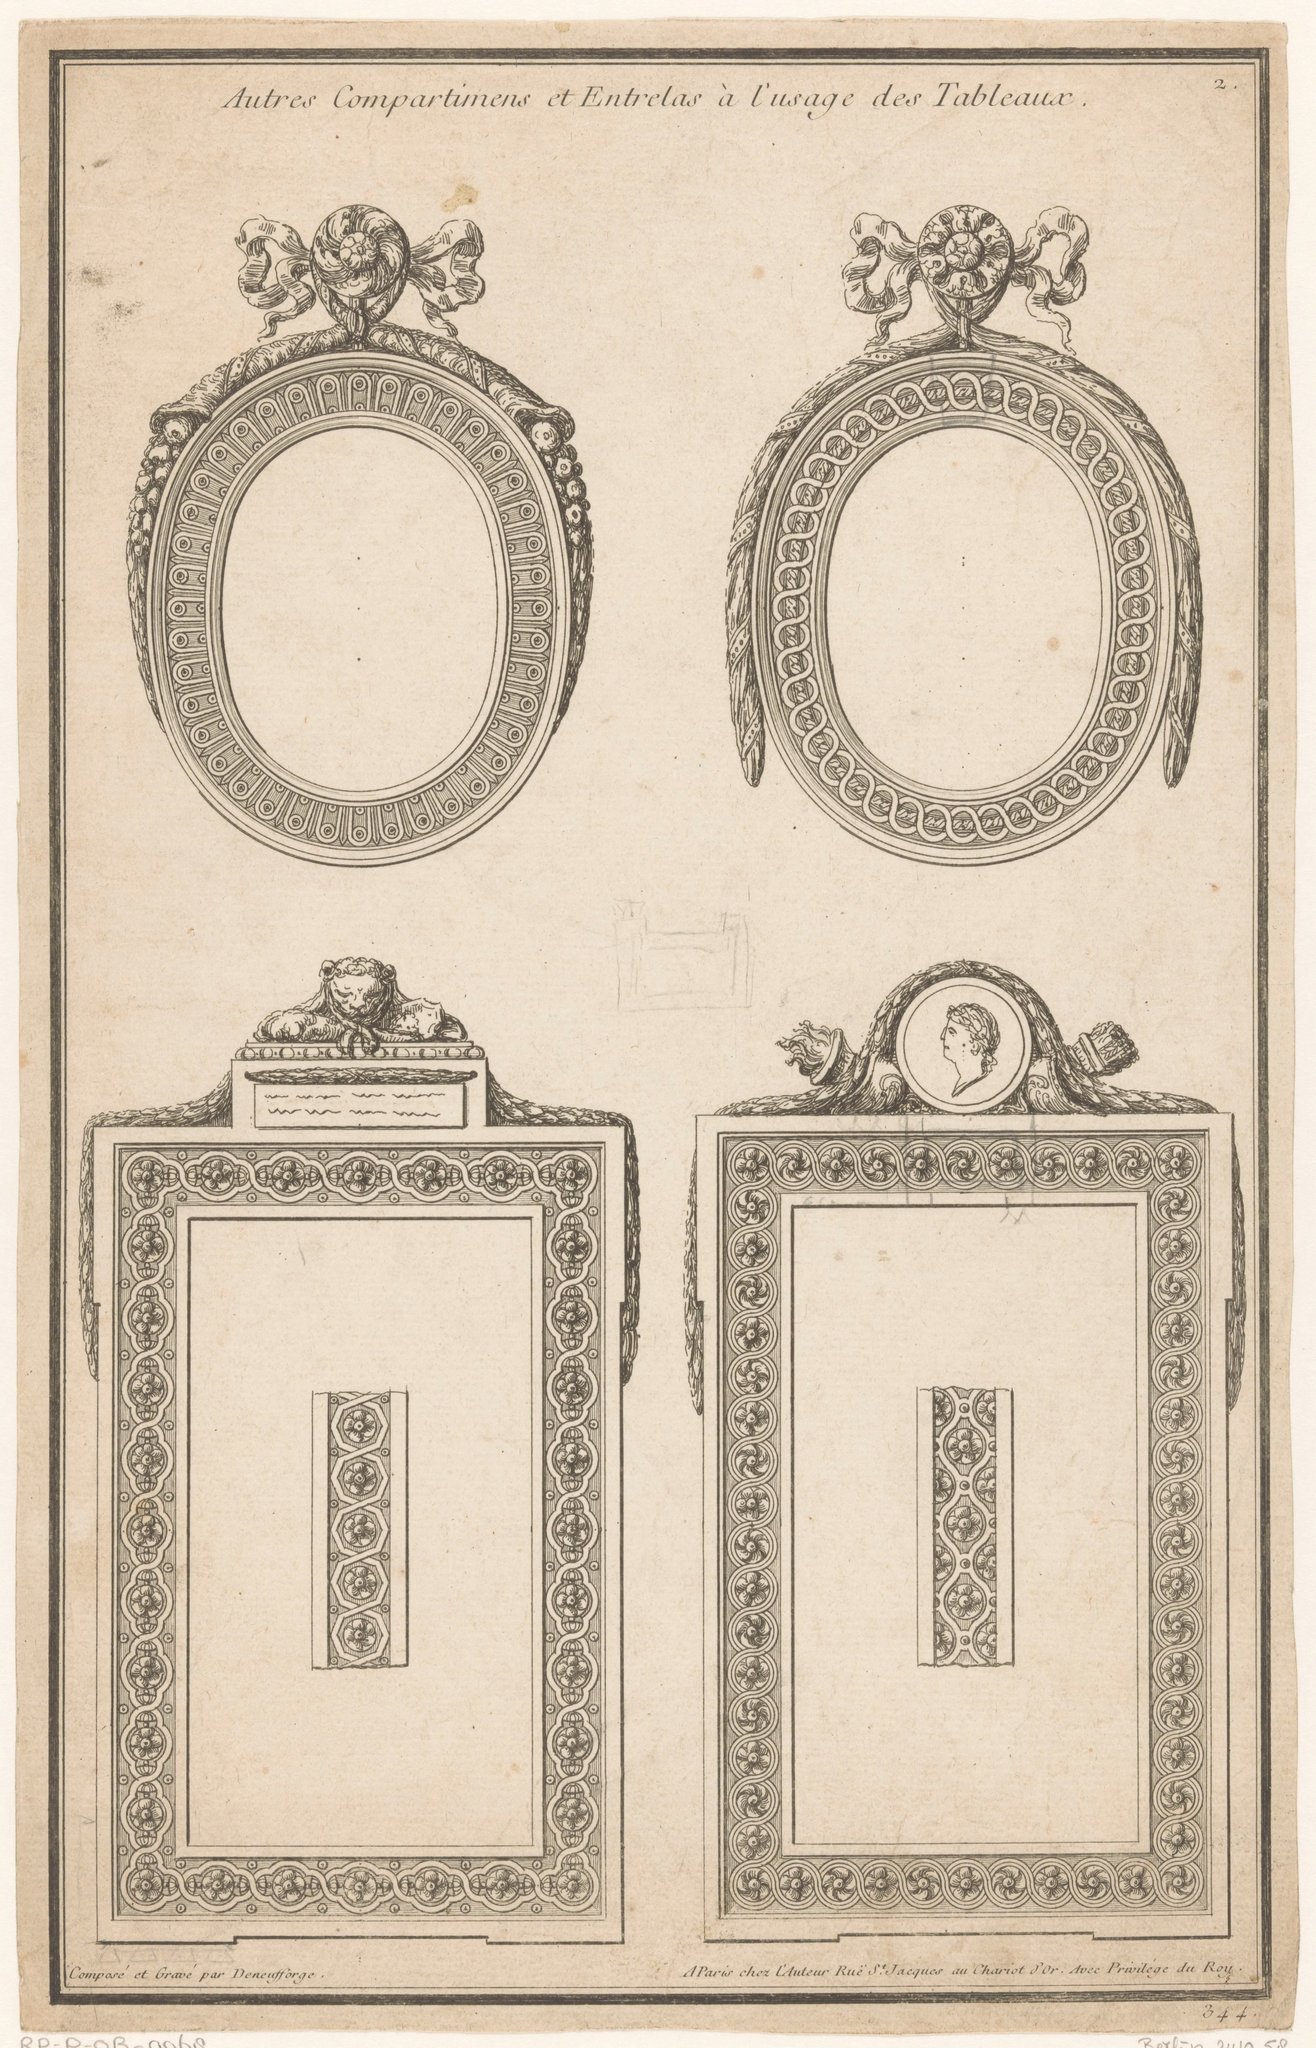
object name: ornament print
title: Autres Compartimens et Entrelas à l'usage des Tableaux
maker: jean françois de neufforge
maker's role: print maker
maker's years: 1714-1791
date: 1763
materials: paper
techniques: etching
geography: paris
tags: ornaments ~ art (+ framing decorations)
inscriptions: collector's mark: Lugt 2228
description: Twee ovale omlijstingen met hoornen des overvloeds en guirlandes. Daaronder twee rechthoekige omlijstingen met bloemmotieven, guirlandes, een leeuw en een medaillons met fakkel en pijlenkoker. Prentnummer 344.